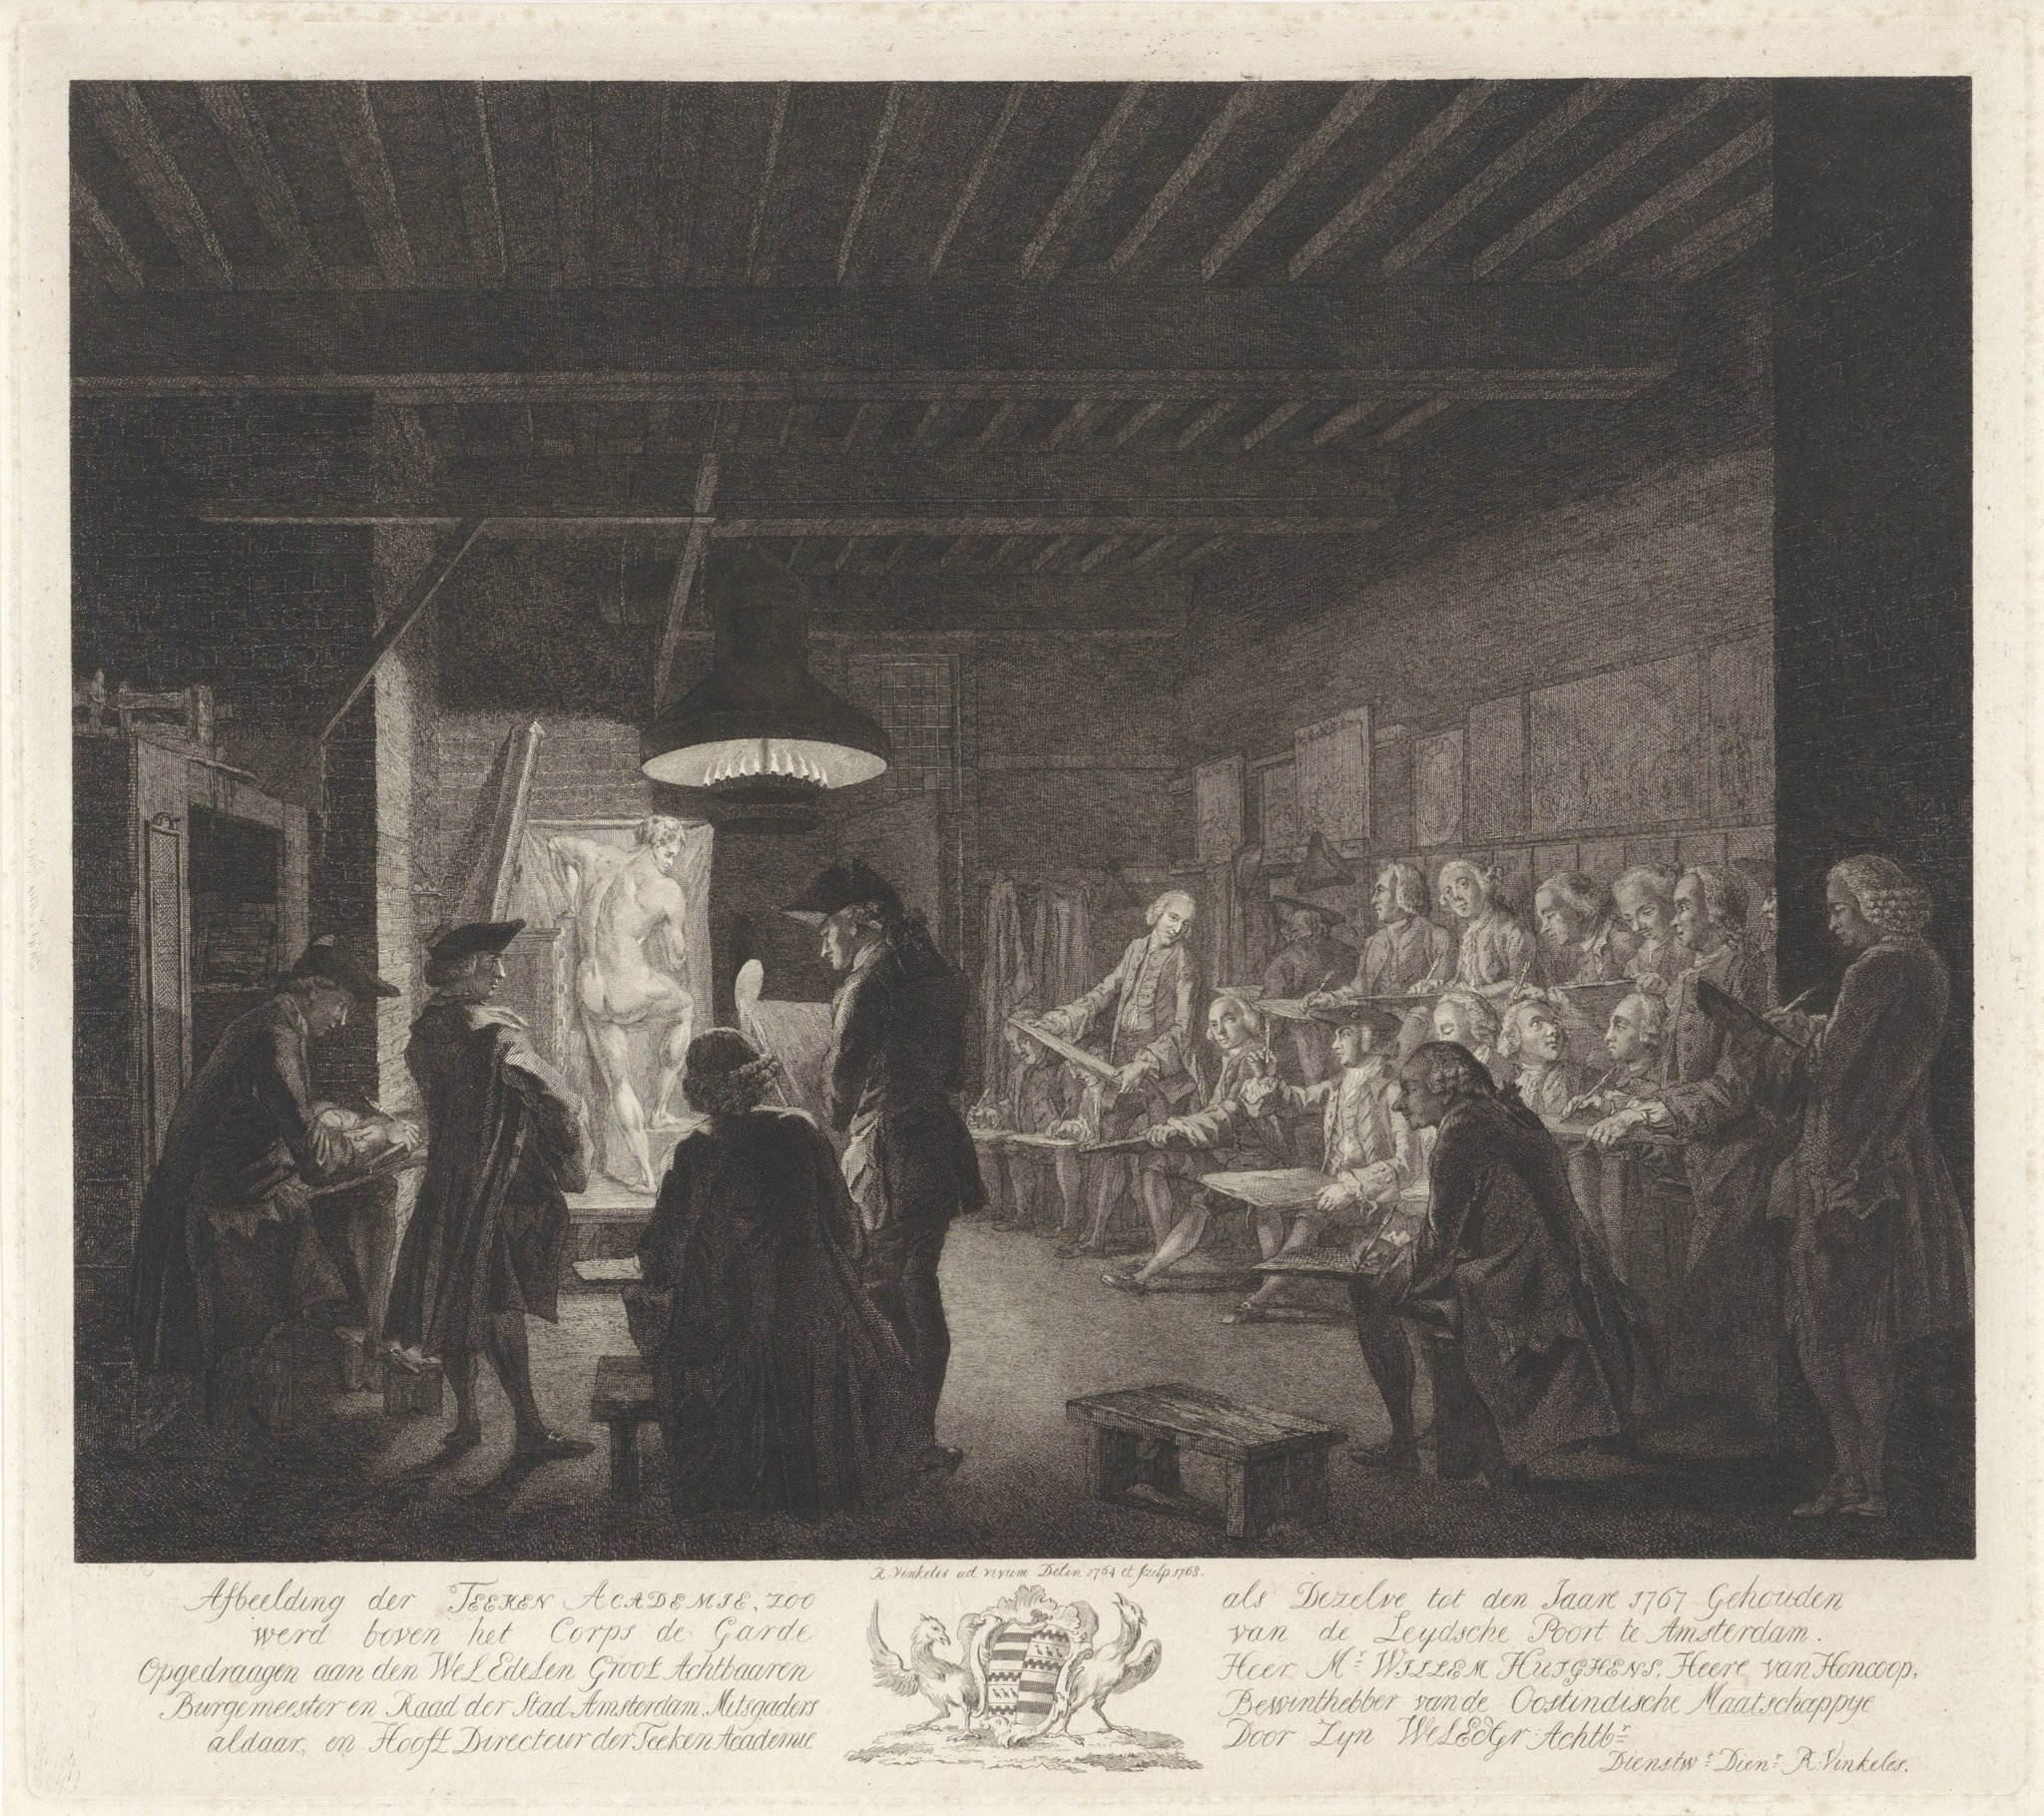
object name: print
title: Stadstekenacademie te Amsterdam, 1764-1767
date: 1768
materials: paper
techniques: engraving, etching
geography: amsterdam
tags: drawing-lesson, place or institution of education and training of the artist, e.g.: academy of art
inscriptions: collector's mark: Lugt 240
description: De stadstekenacademie (Teeken-Academie) boven het Corps de Garde in de Leidsepoort te Amsterdam in het jaar 1764. De tekenacademie verhuisde op 4 december 1767 naar het stadhuis op de Dam. Een groep mannelijke tekenleerlingen in een vrij donker interieur bij lamplicht tekenend naar een mannelijk naaktmodel, het model staand van achteren gezien. In de marge onderaan de titel en de opdracht aan Willem Huyghens met zijn familiewapen.